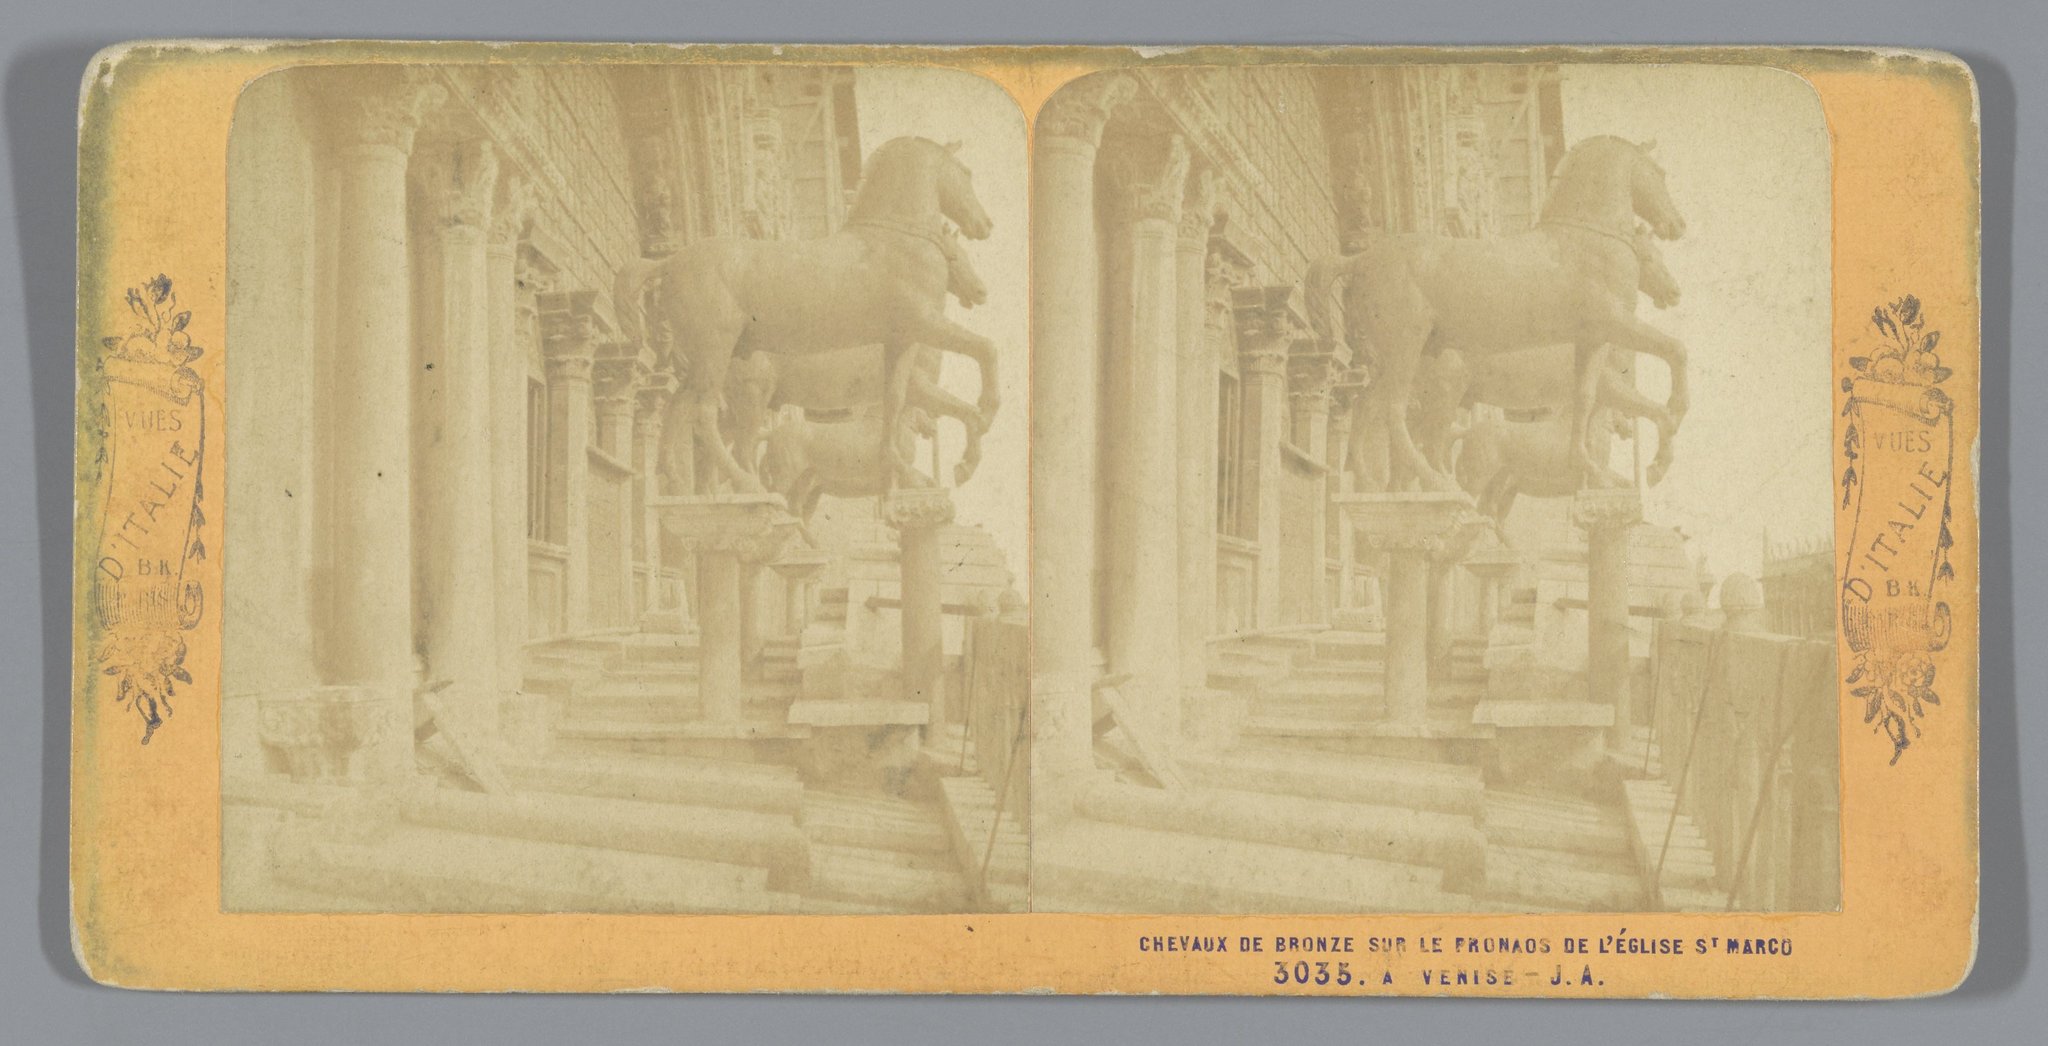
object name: stereograph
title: Vues d'Italie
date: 1872-1876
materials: cardboard, paper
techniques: albumen print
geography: venice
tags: church (exterior), sculpture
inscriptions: number: ‘3035’